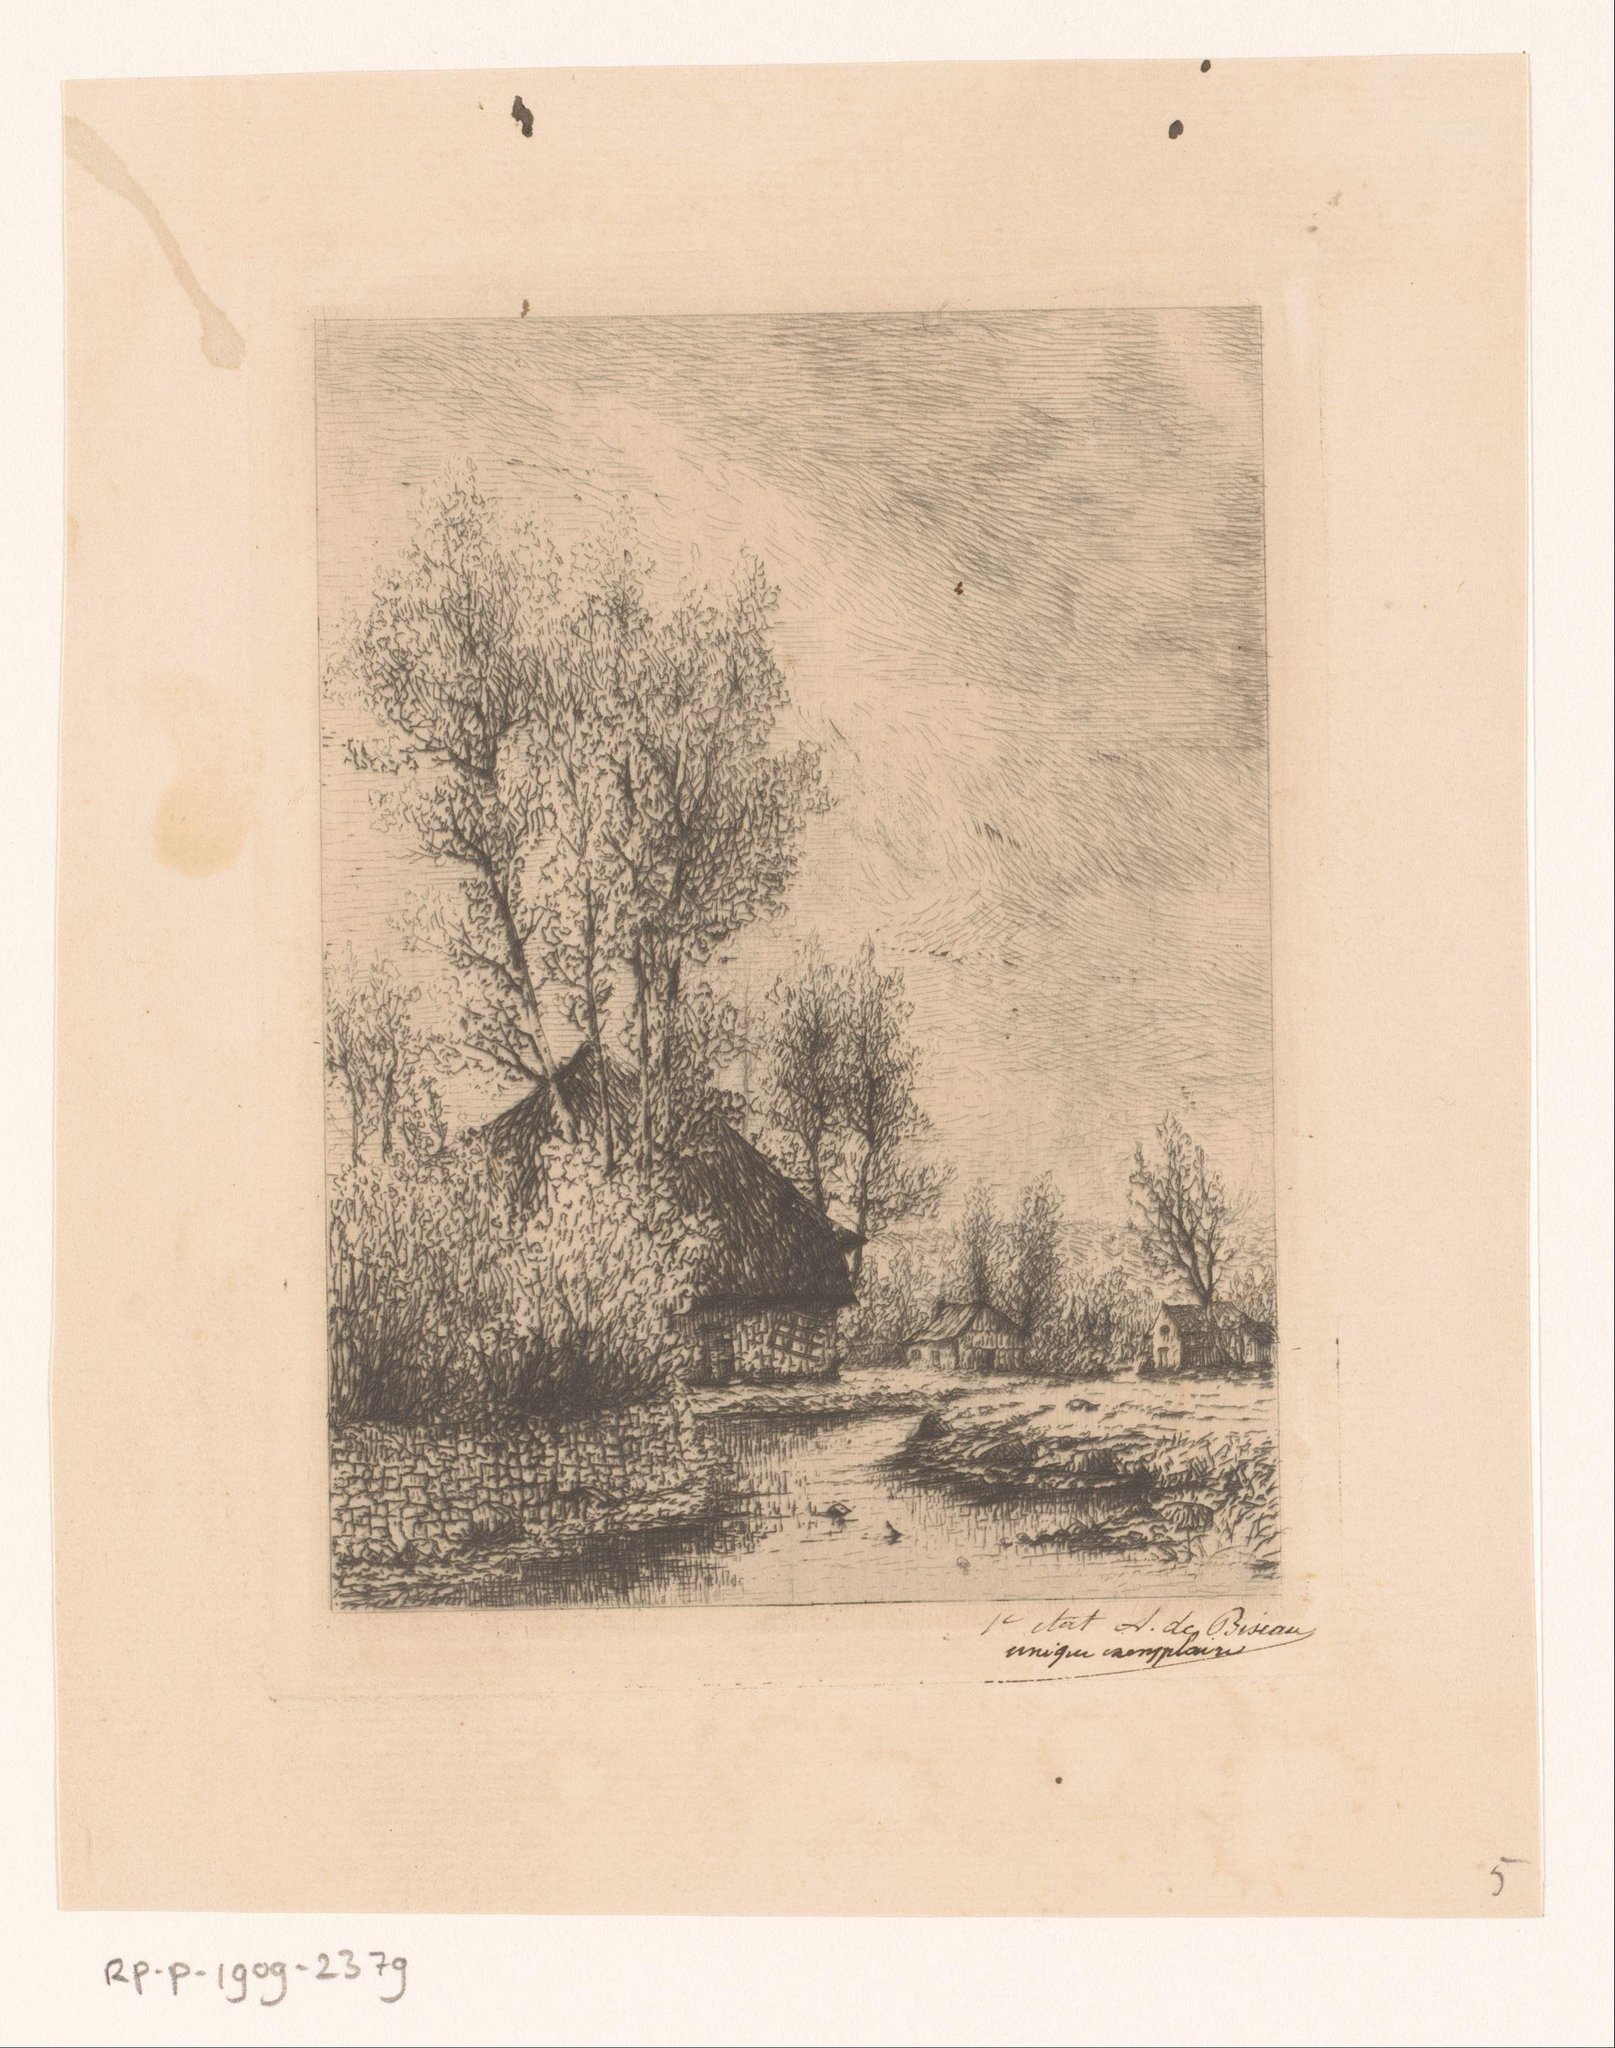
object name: print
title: Boerenwoningen gelegen aan een beek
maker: aristide de biseau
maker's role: print maker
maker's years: 1844-1883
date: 1854-1883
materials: paper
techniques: drypoint, etching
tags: landscapes, water course, farm or solitary house in landscape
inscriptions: collector's mark: Lugt 2228, inscription: ‘1e etat unique exemplaire’